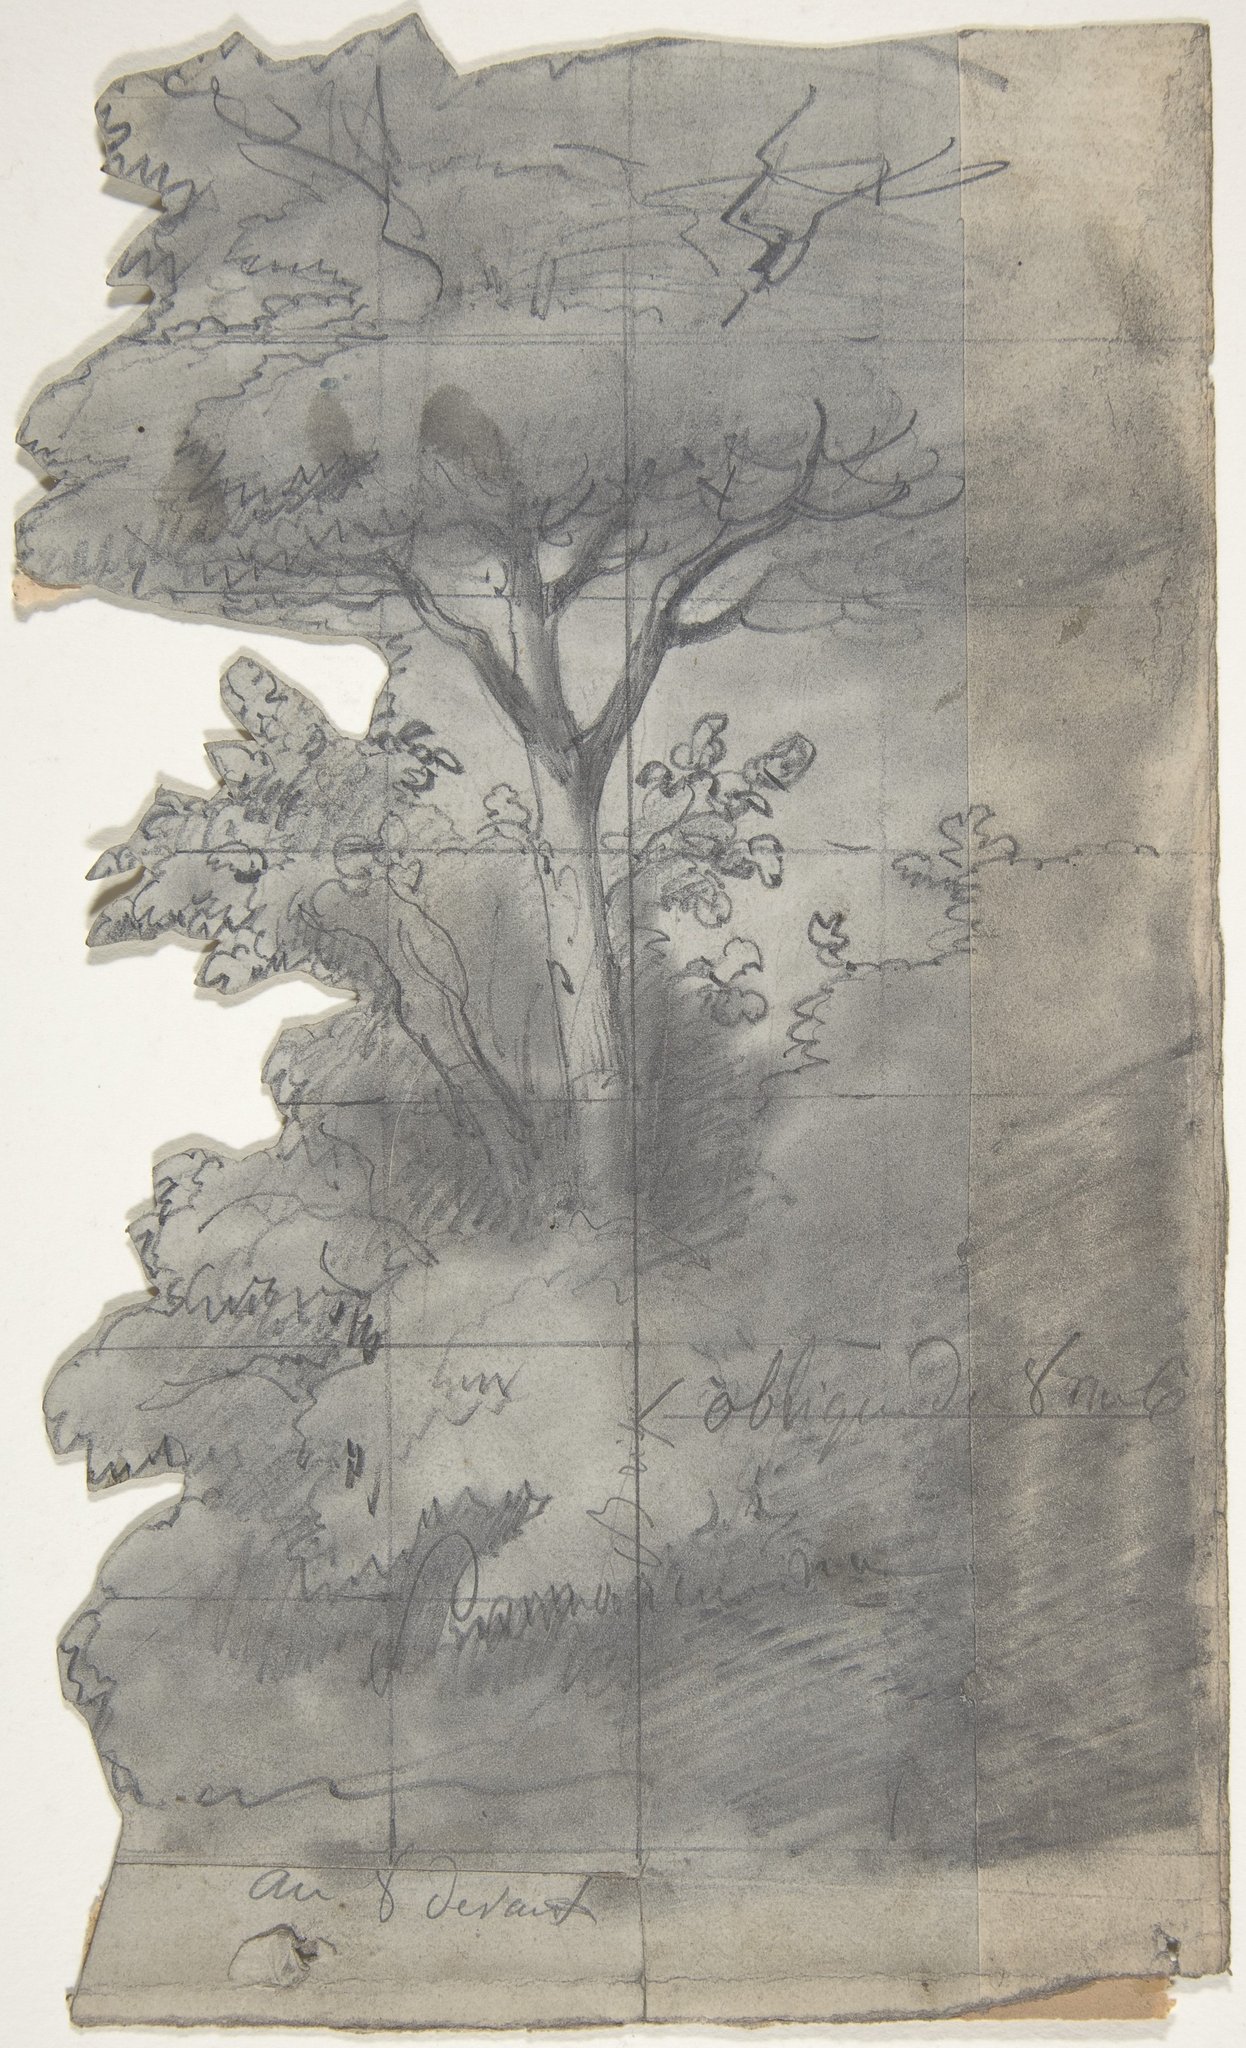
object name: drawing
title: Design for a Stage Set at the Opéra, Paris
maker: eugène cicéri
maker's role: artist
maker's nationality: french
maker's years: 1813-1890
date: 1830-1890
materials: graphite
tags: trees,stage design